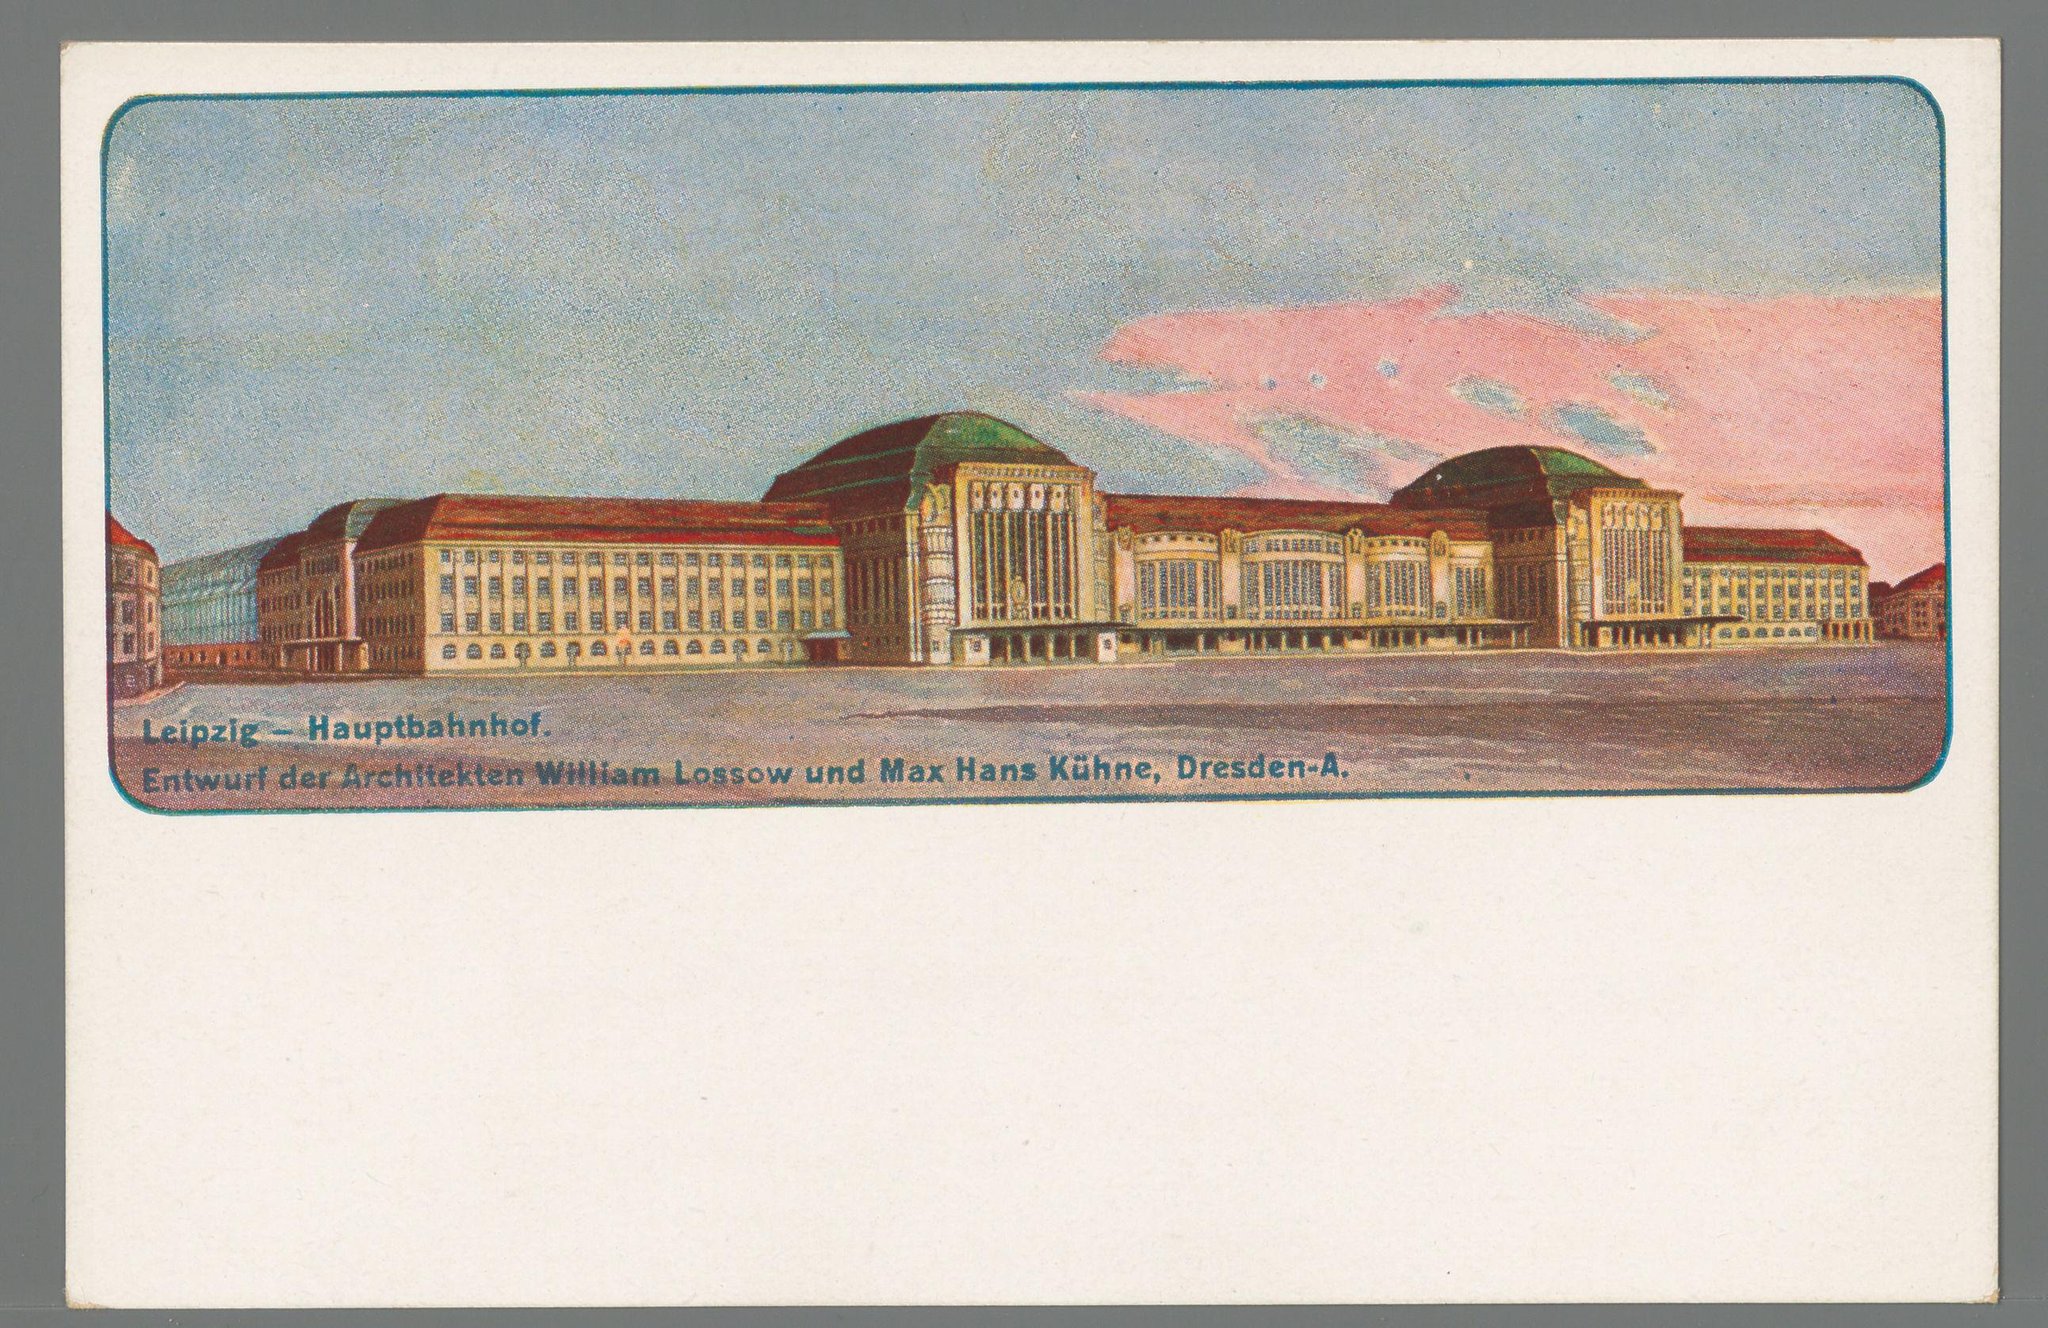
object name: photomechanical print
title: Leipzig - Hauptbahnhof. Entwurf der Architekten William Lossow und Max Hans Kühne, Dresden-A.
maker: Anonymous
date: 1908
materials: cardboard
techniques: writing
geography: leipzig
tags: station; shelter (railway, tramway)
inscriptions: date